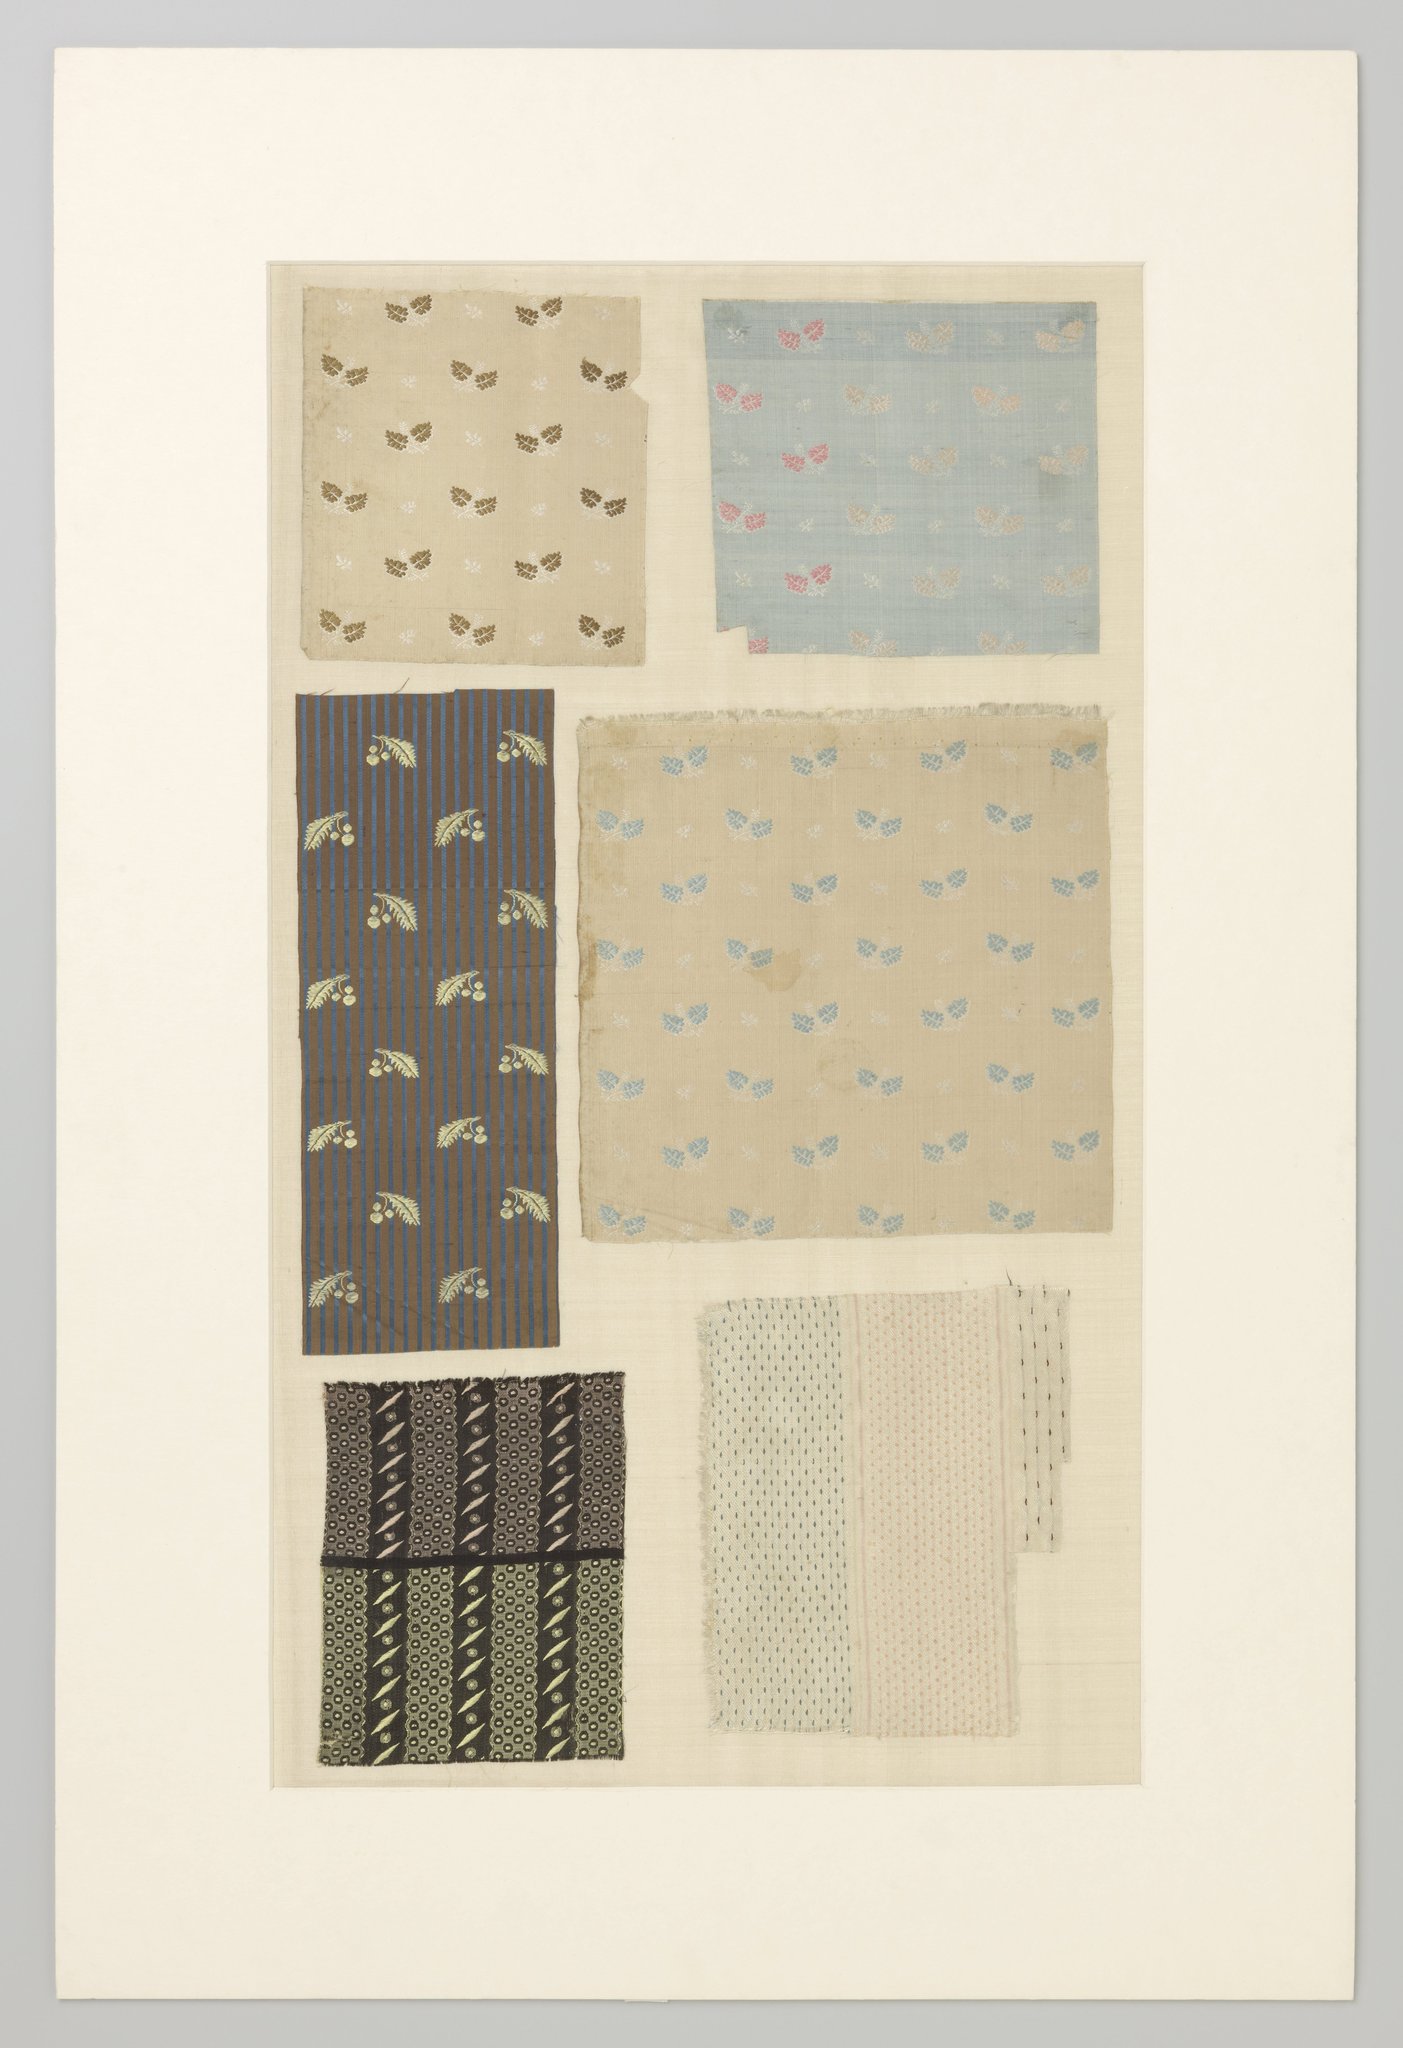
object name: fragment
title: Fragment zijdeweefsel.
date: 1750-1800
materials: silk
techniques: weave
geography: haarlem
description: Fragment zijdeweefsel. Een roze grond heeft een patroon van rijen dubbele, lichtblauwe bladeren op een witte steel, waartussen een kleine witte tak.